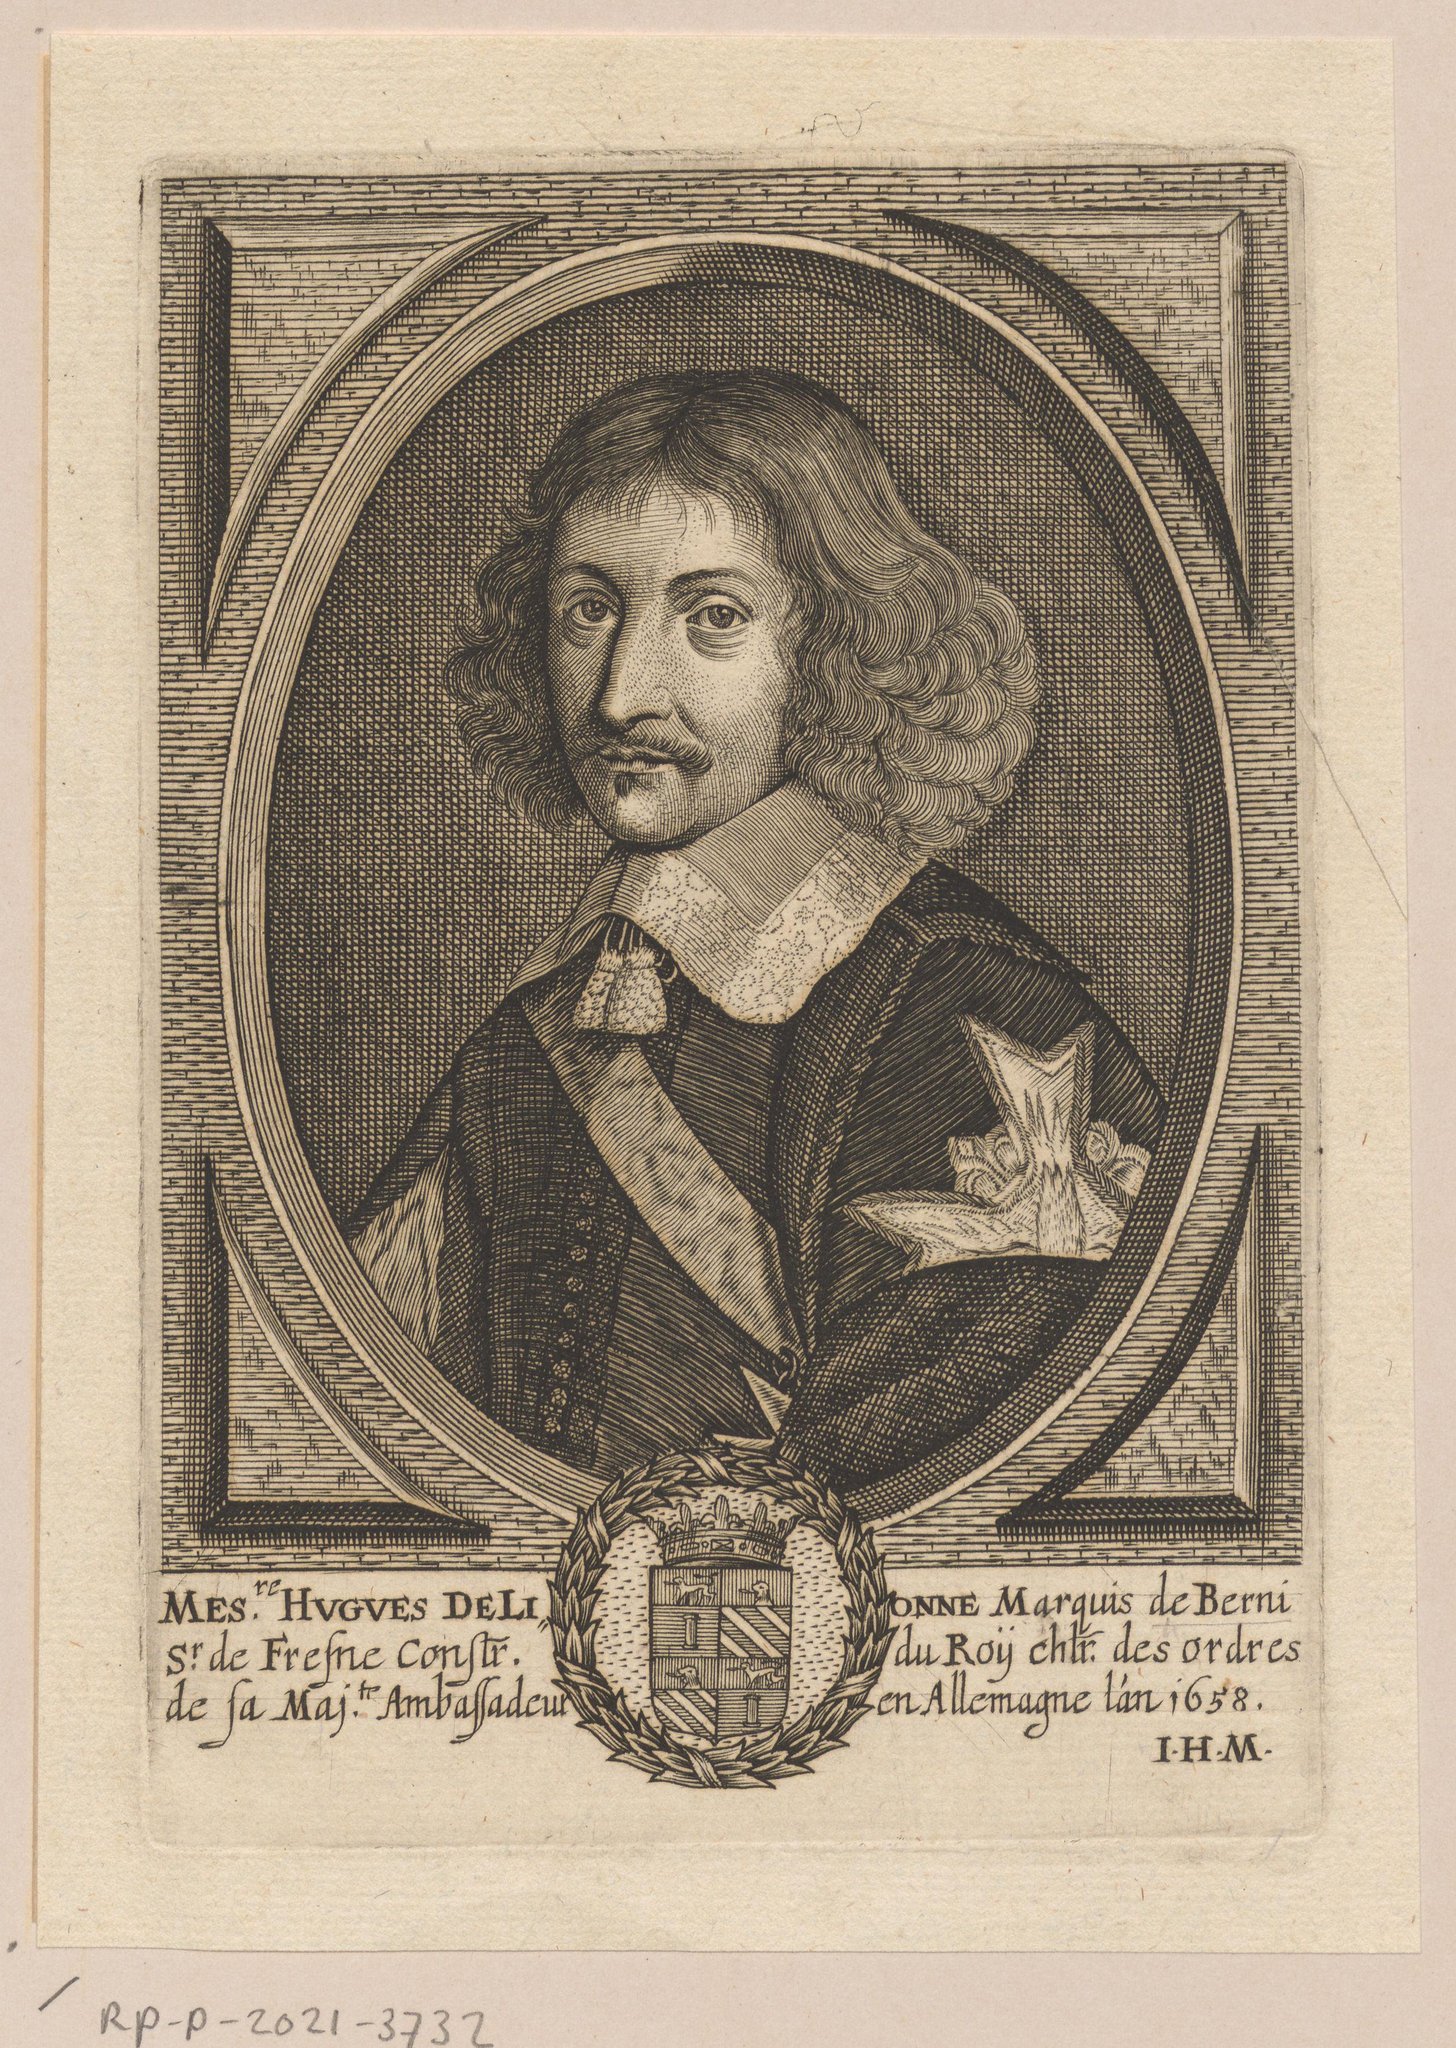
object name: print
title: Portret van Hugues de Lionne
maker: Anonymous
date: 1658-1680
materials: paper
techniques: engraving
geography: france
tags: paris, ornament ~ medallion, historical persons, politician, e.g. party leader, armorial bearing, heraldry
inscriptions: monogram: ‘I.H.M.’